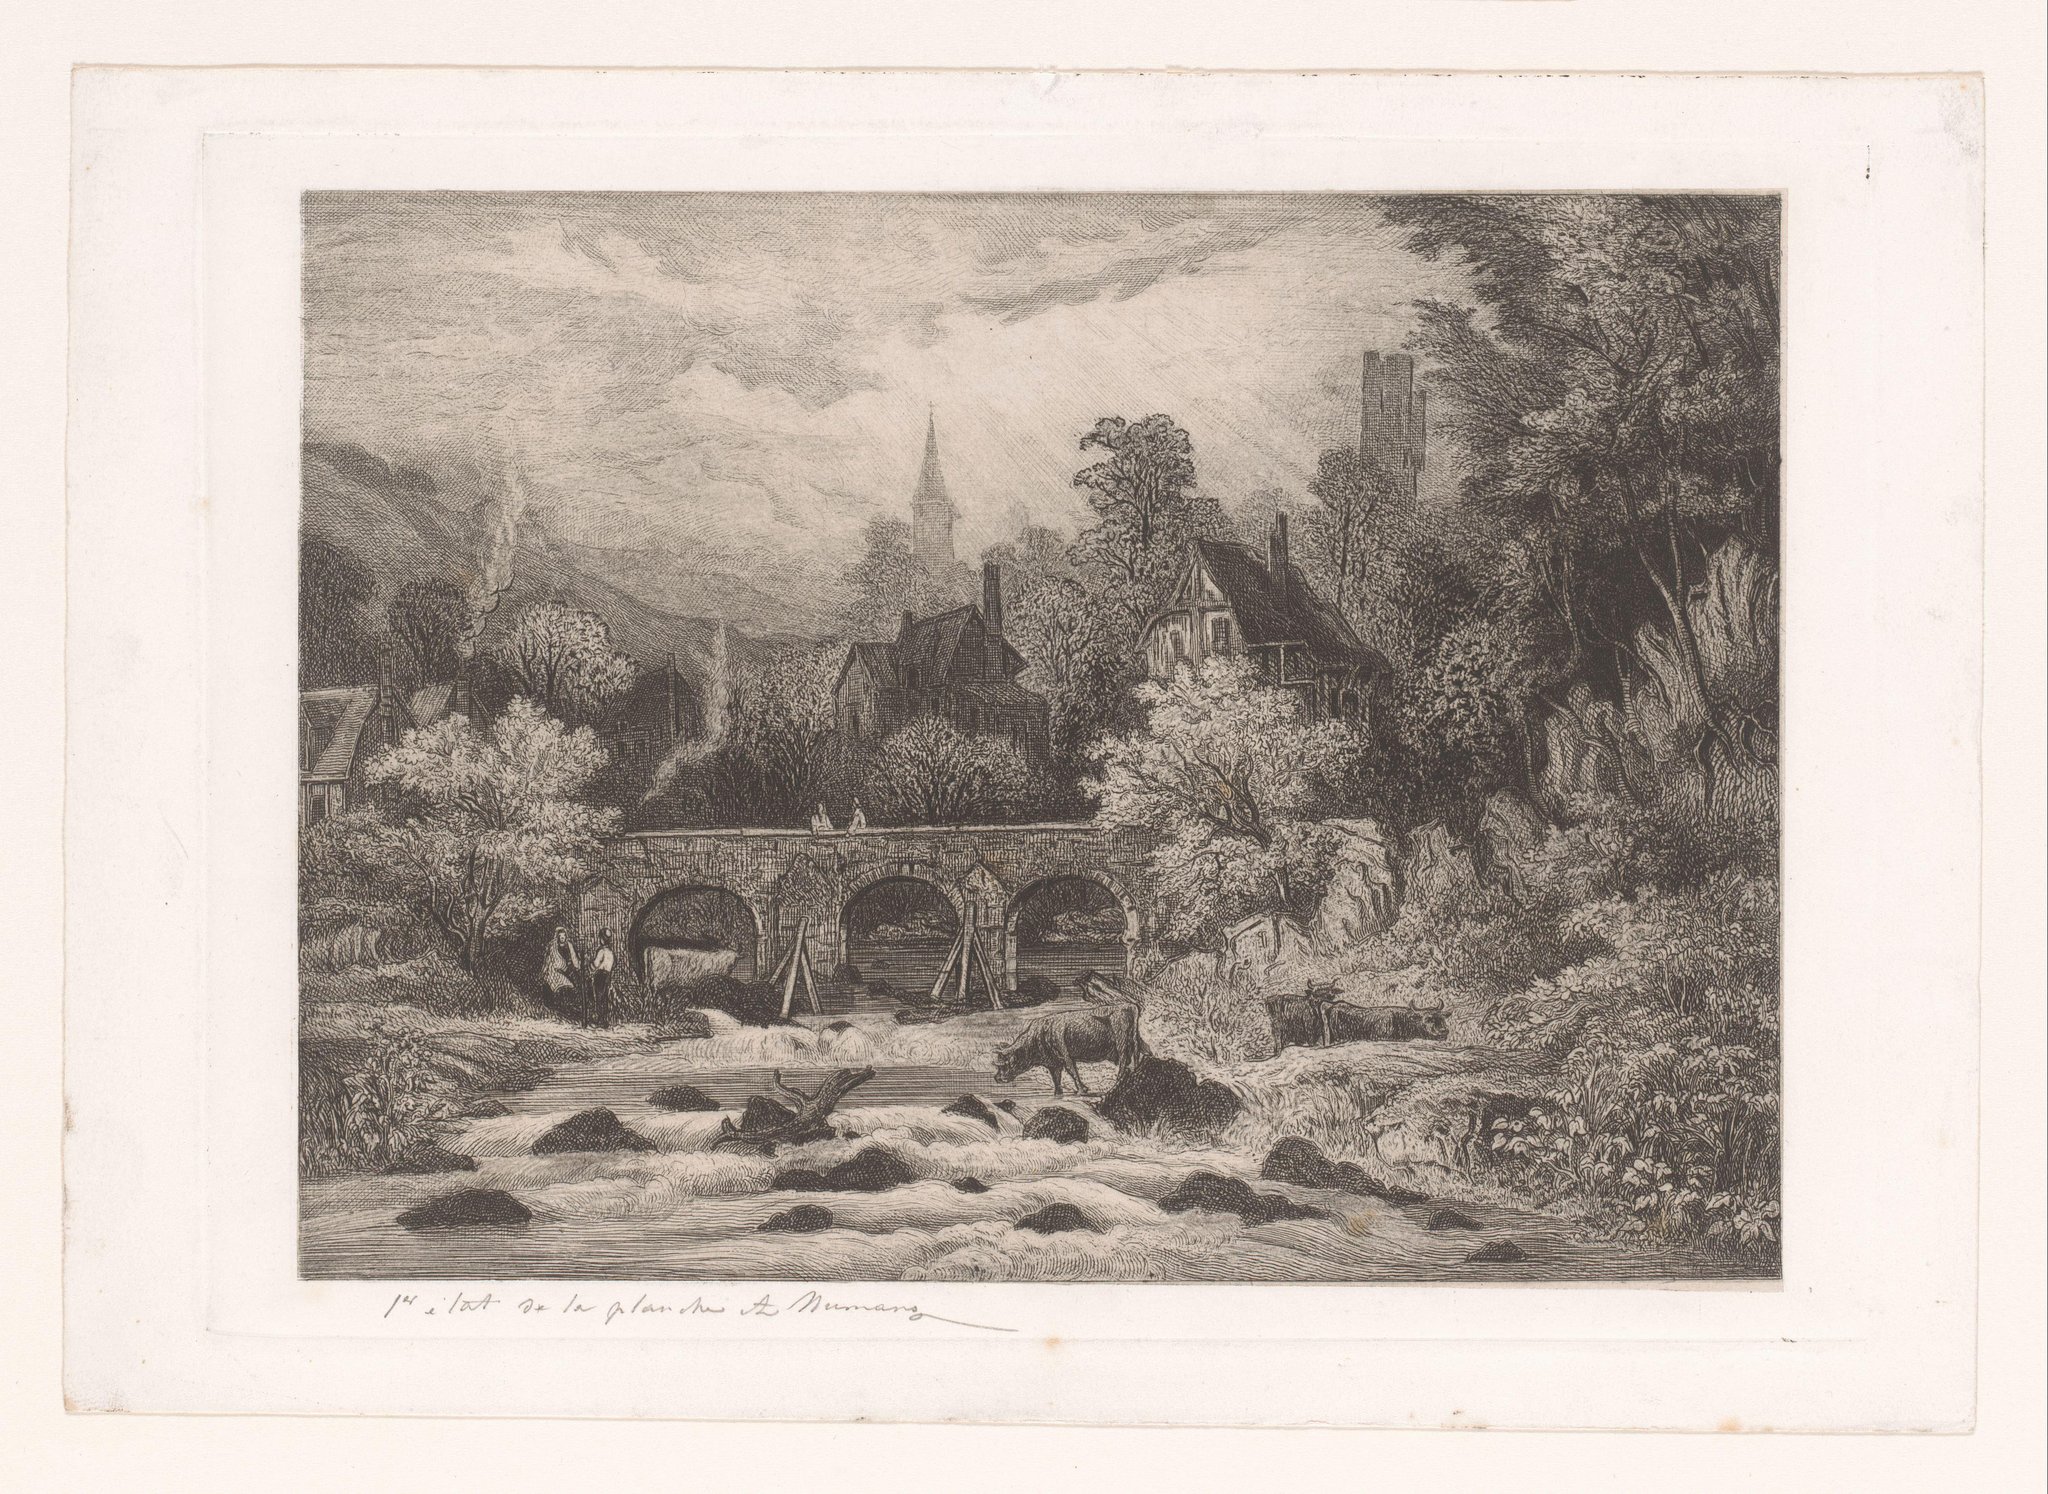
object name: print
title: Landschap met dorp in een bergdal langs een rivier met brug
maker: auguste numans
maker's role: print maker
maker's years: 1823-1883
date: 1833-1879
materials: paper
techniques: etching, intaglio, roulette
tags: prospect of village, silhouette of village, cow, river (+ landscape with figures, staffage), bridge in village across river, canal, etc.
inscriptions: collector's mark: Lugt 2228, inscription: ‘1e etat de la planche A Numans’